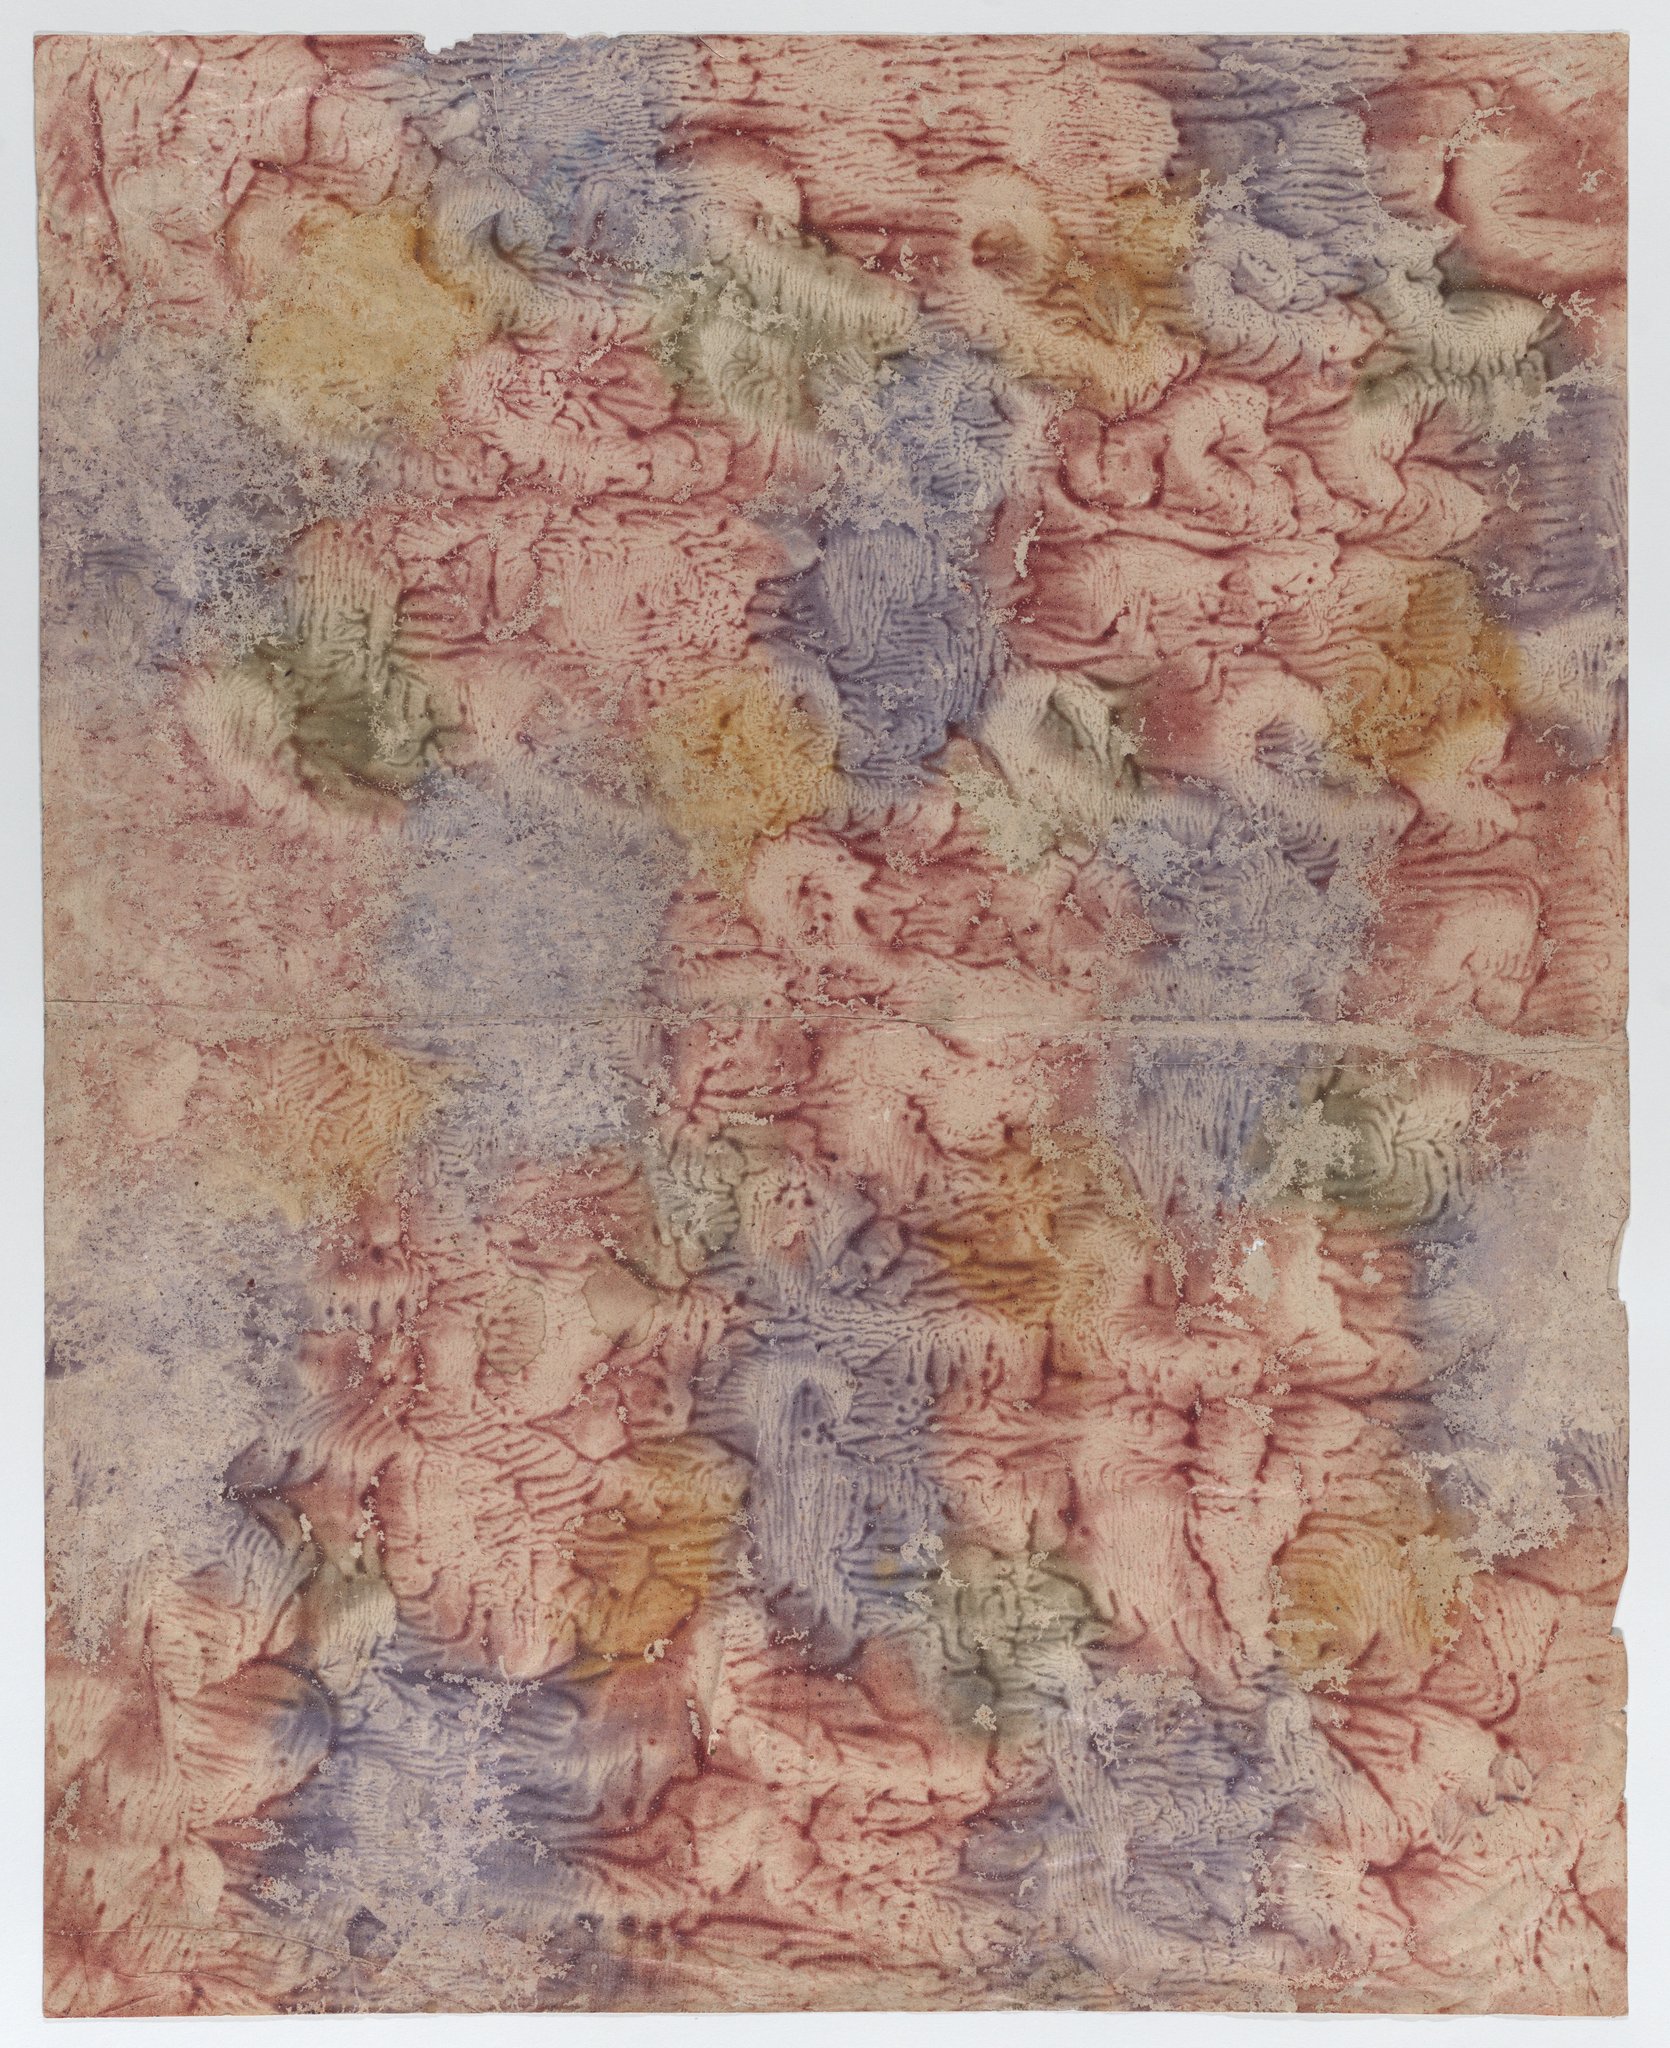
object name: print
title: Book cover with purple, green, red, and yellow pattern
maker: Anonymous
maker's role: artist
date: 1701-1800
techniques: relief print